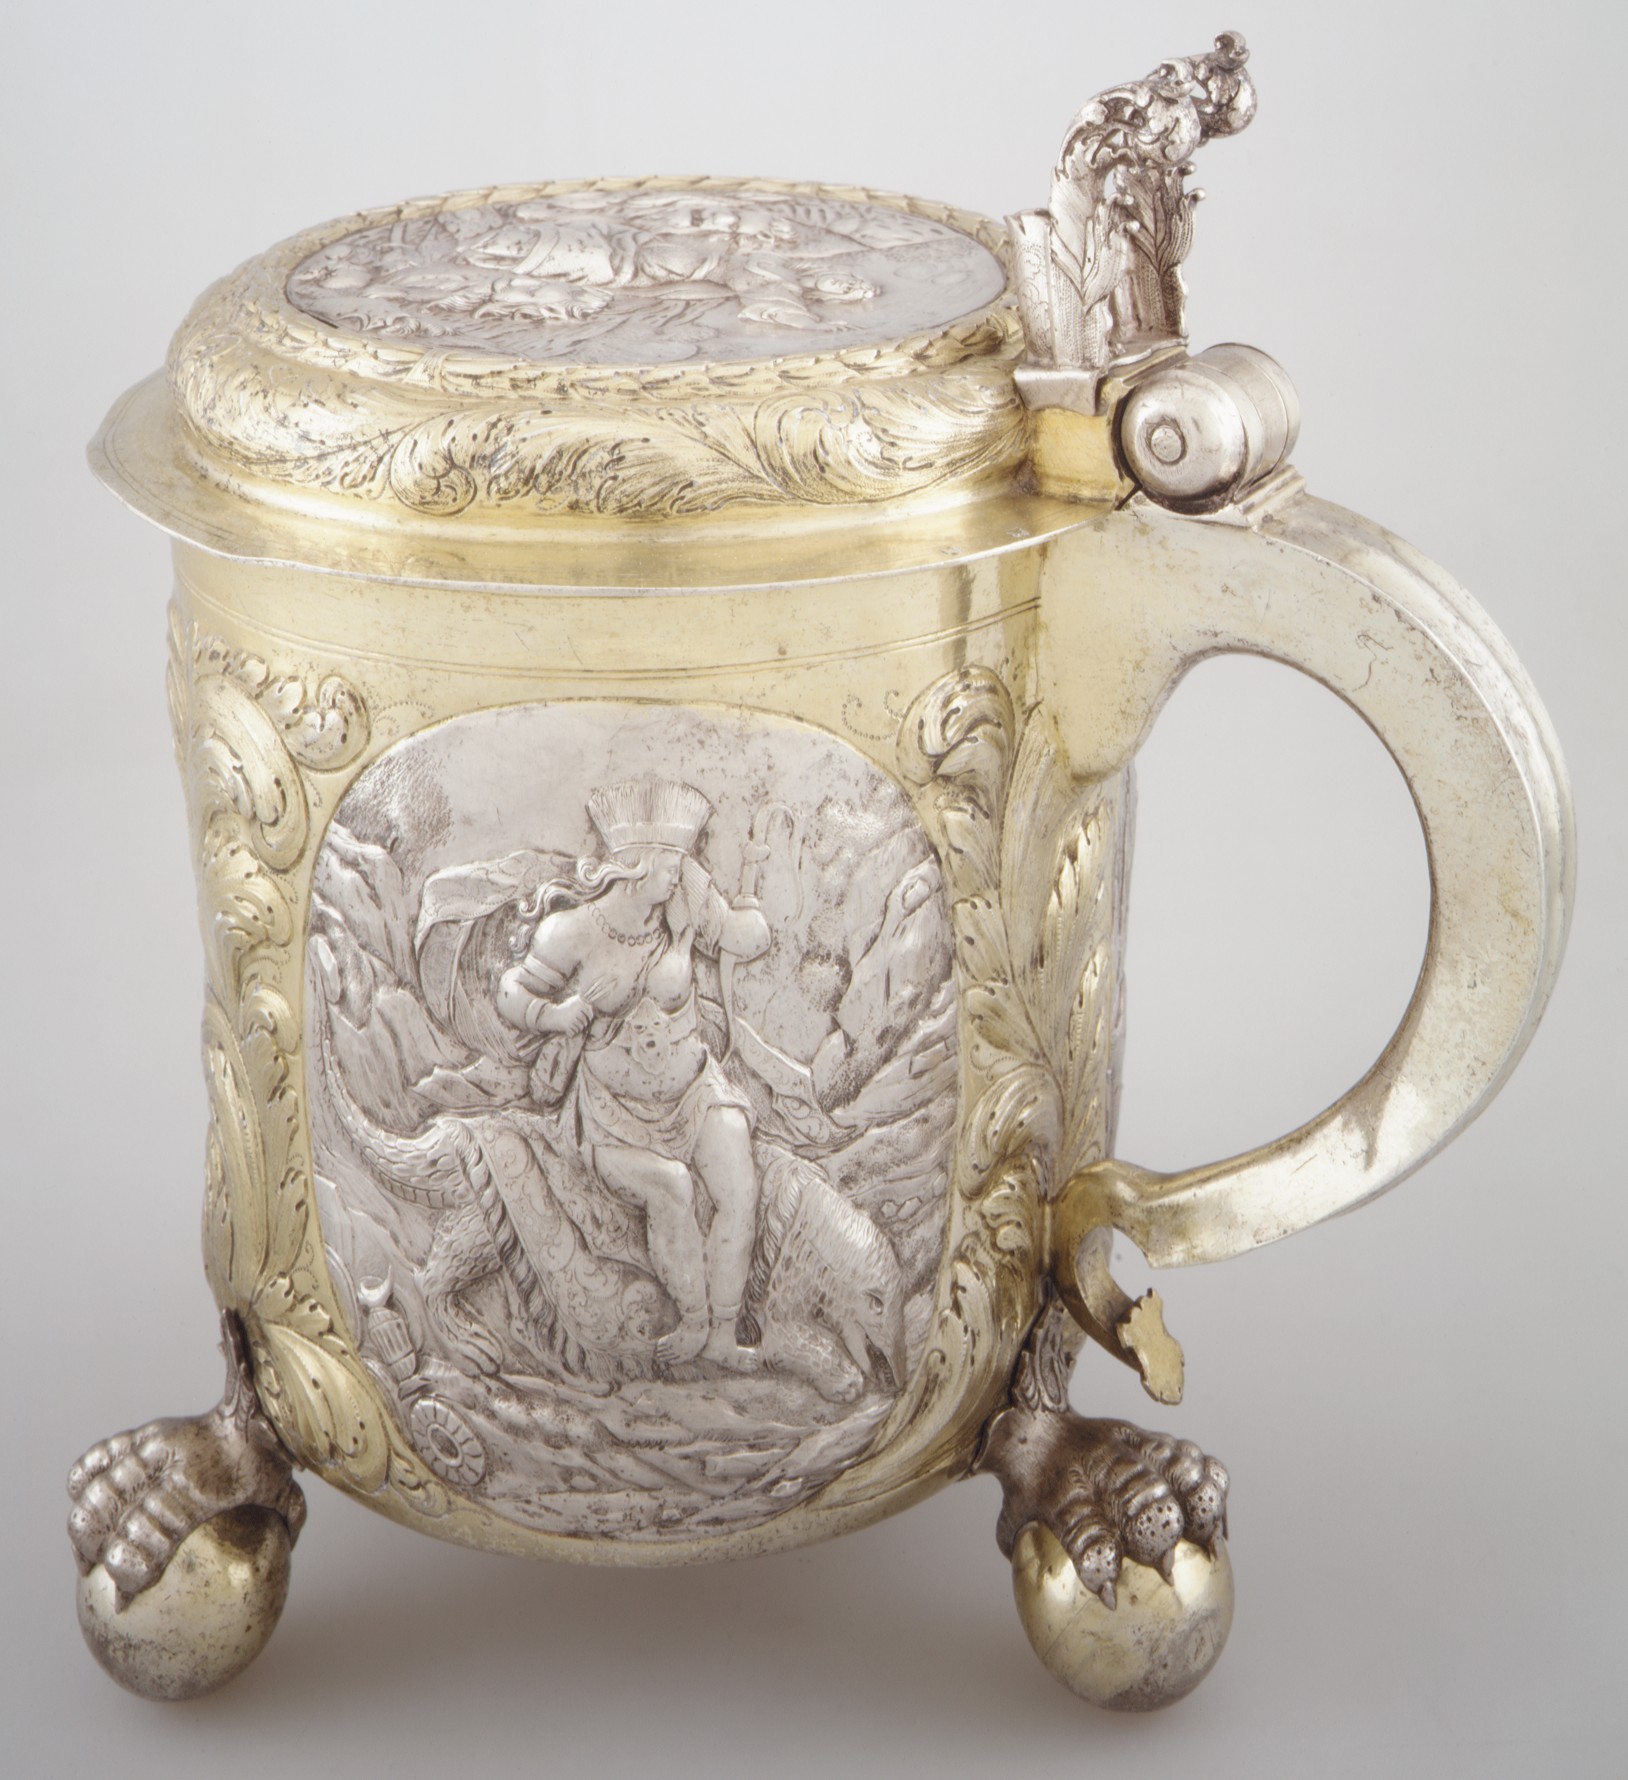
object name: tankard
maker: hans nicolaus müllner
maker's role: artist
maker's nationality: german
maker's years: 1644-1688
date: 1667-1700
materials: silver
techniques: gilding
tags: animals,female nudes